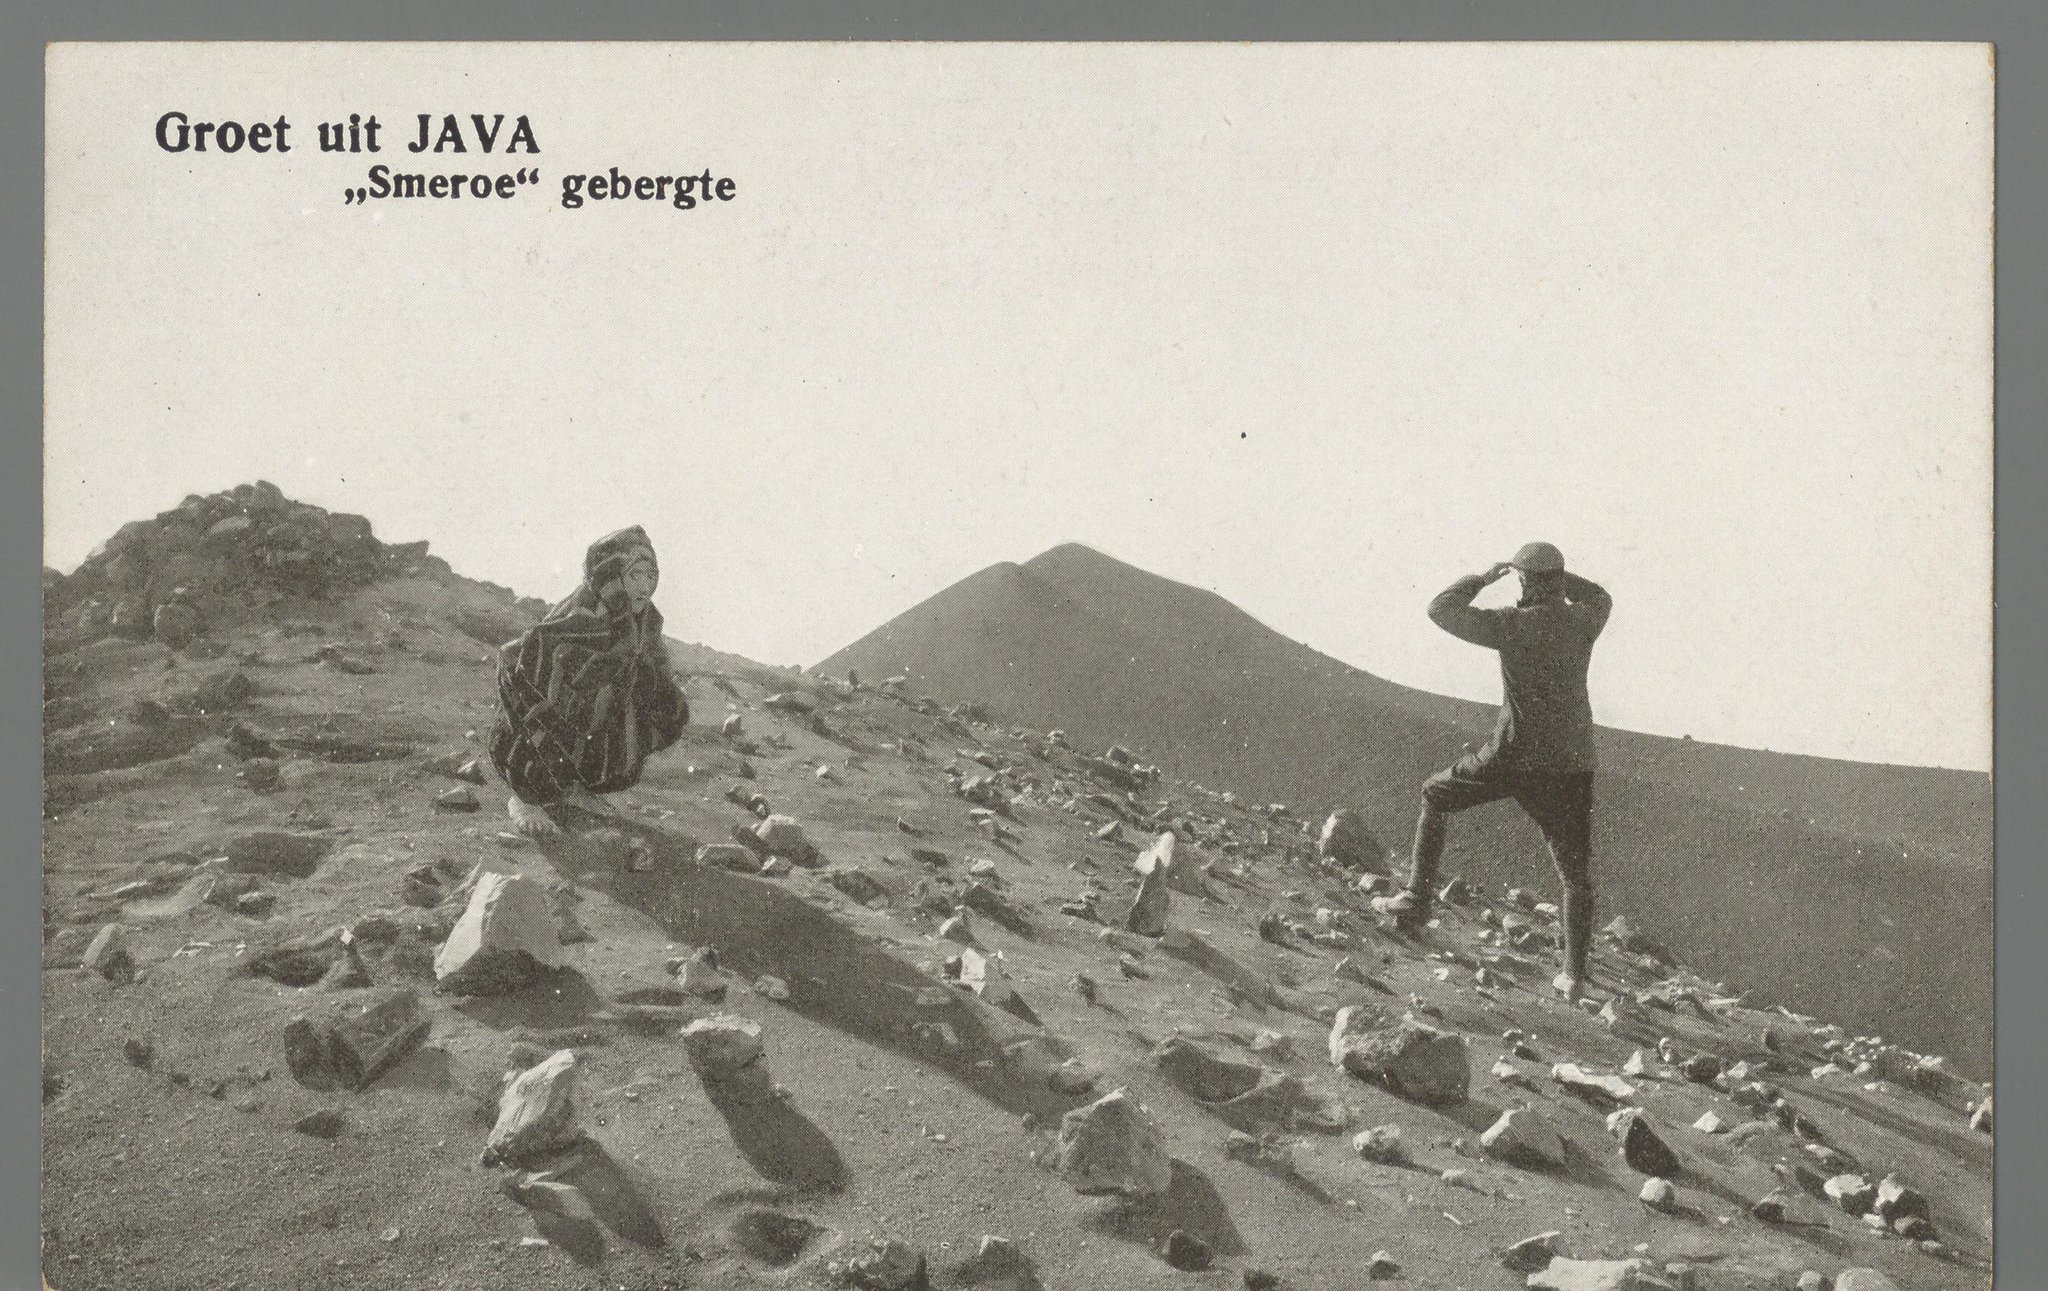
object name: ansichtkaart, prentbriefkaart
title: Groet uit Java. "Smeroe" gebergte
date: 1906-1930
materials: cardboard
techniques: autotype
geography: weltevreden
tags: mountains